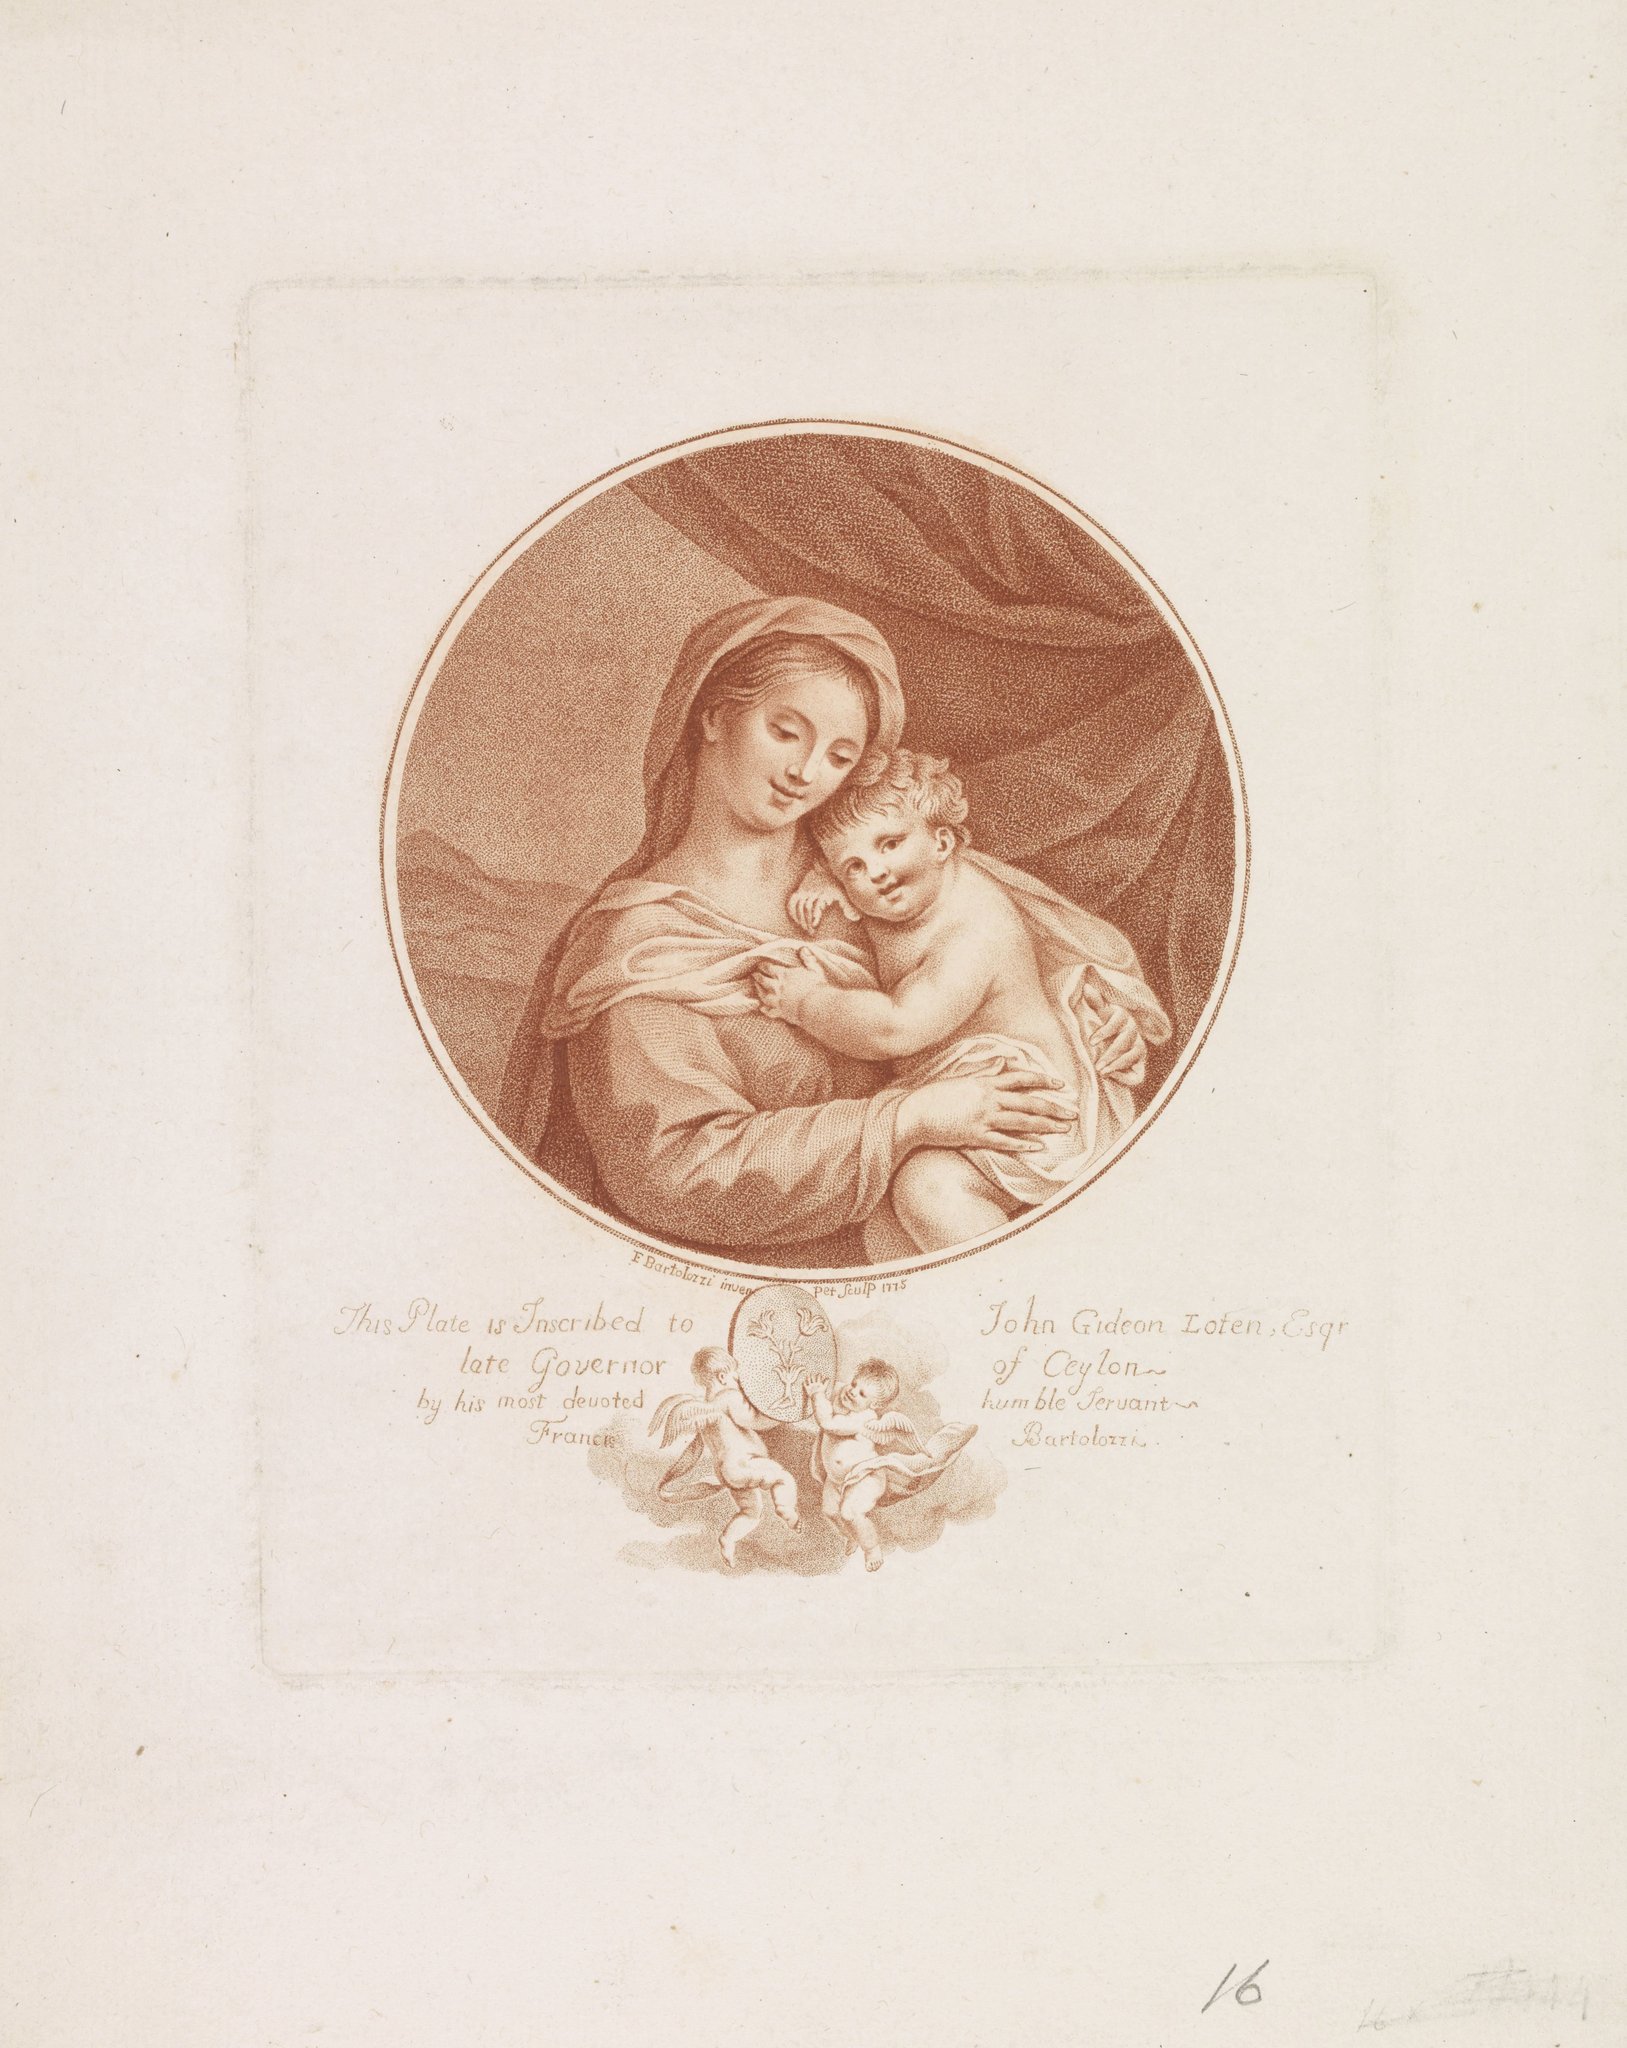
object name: print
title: Maria met kind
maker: francesco bartolozzi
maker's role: draughtsman, print maker, publisher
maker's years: 1727-1815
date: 1775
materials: paper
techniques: engraving, etching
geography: italy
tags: madonna: i.e. mary with the christ-child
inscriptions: collector's mark: Lugt 240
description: Maria met het Christuskind op haar schoot. In de ondermarge tekst en een schild gedragen door twee putti.